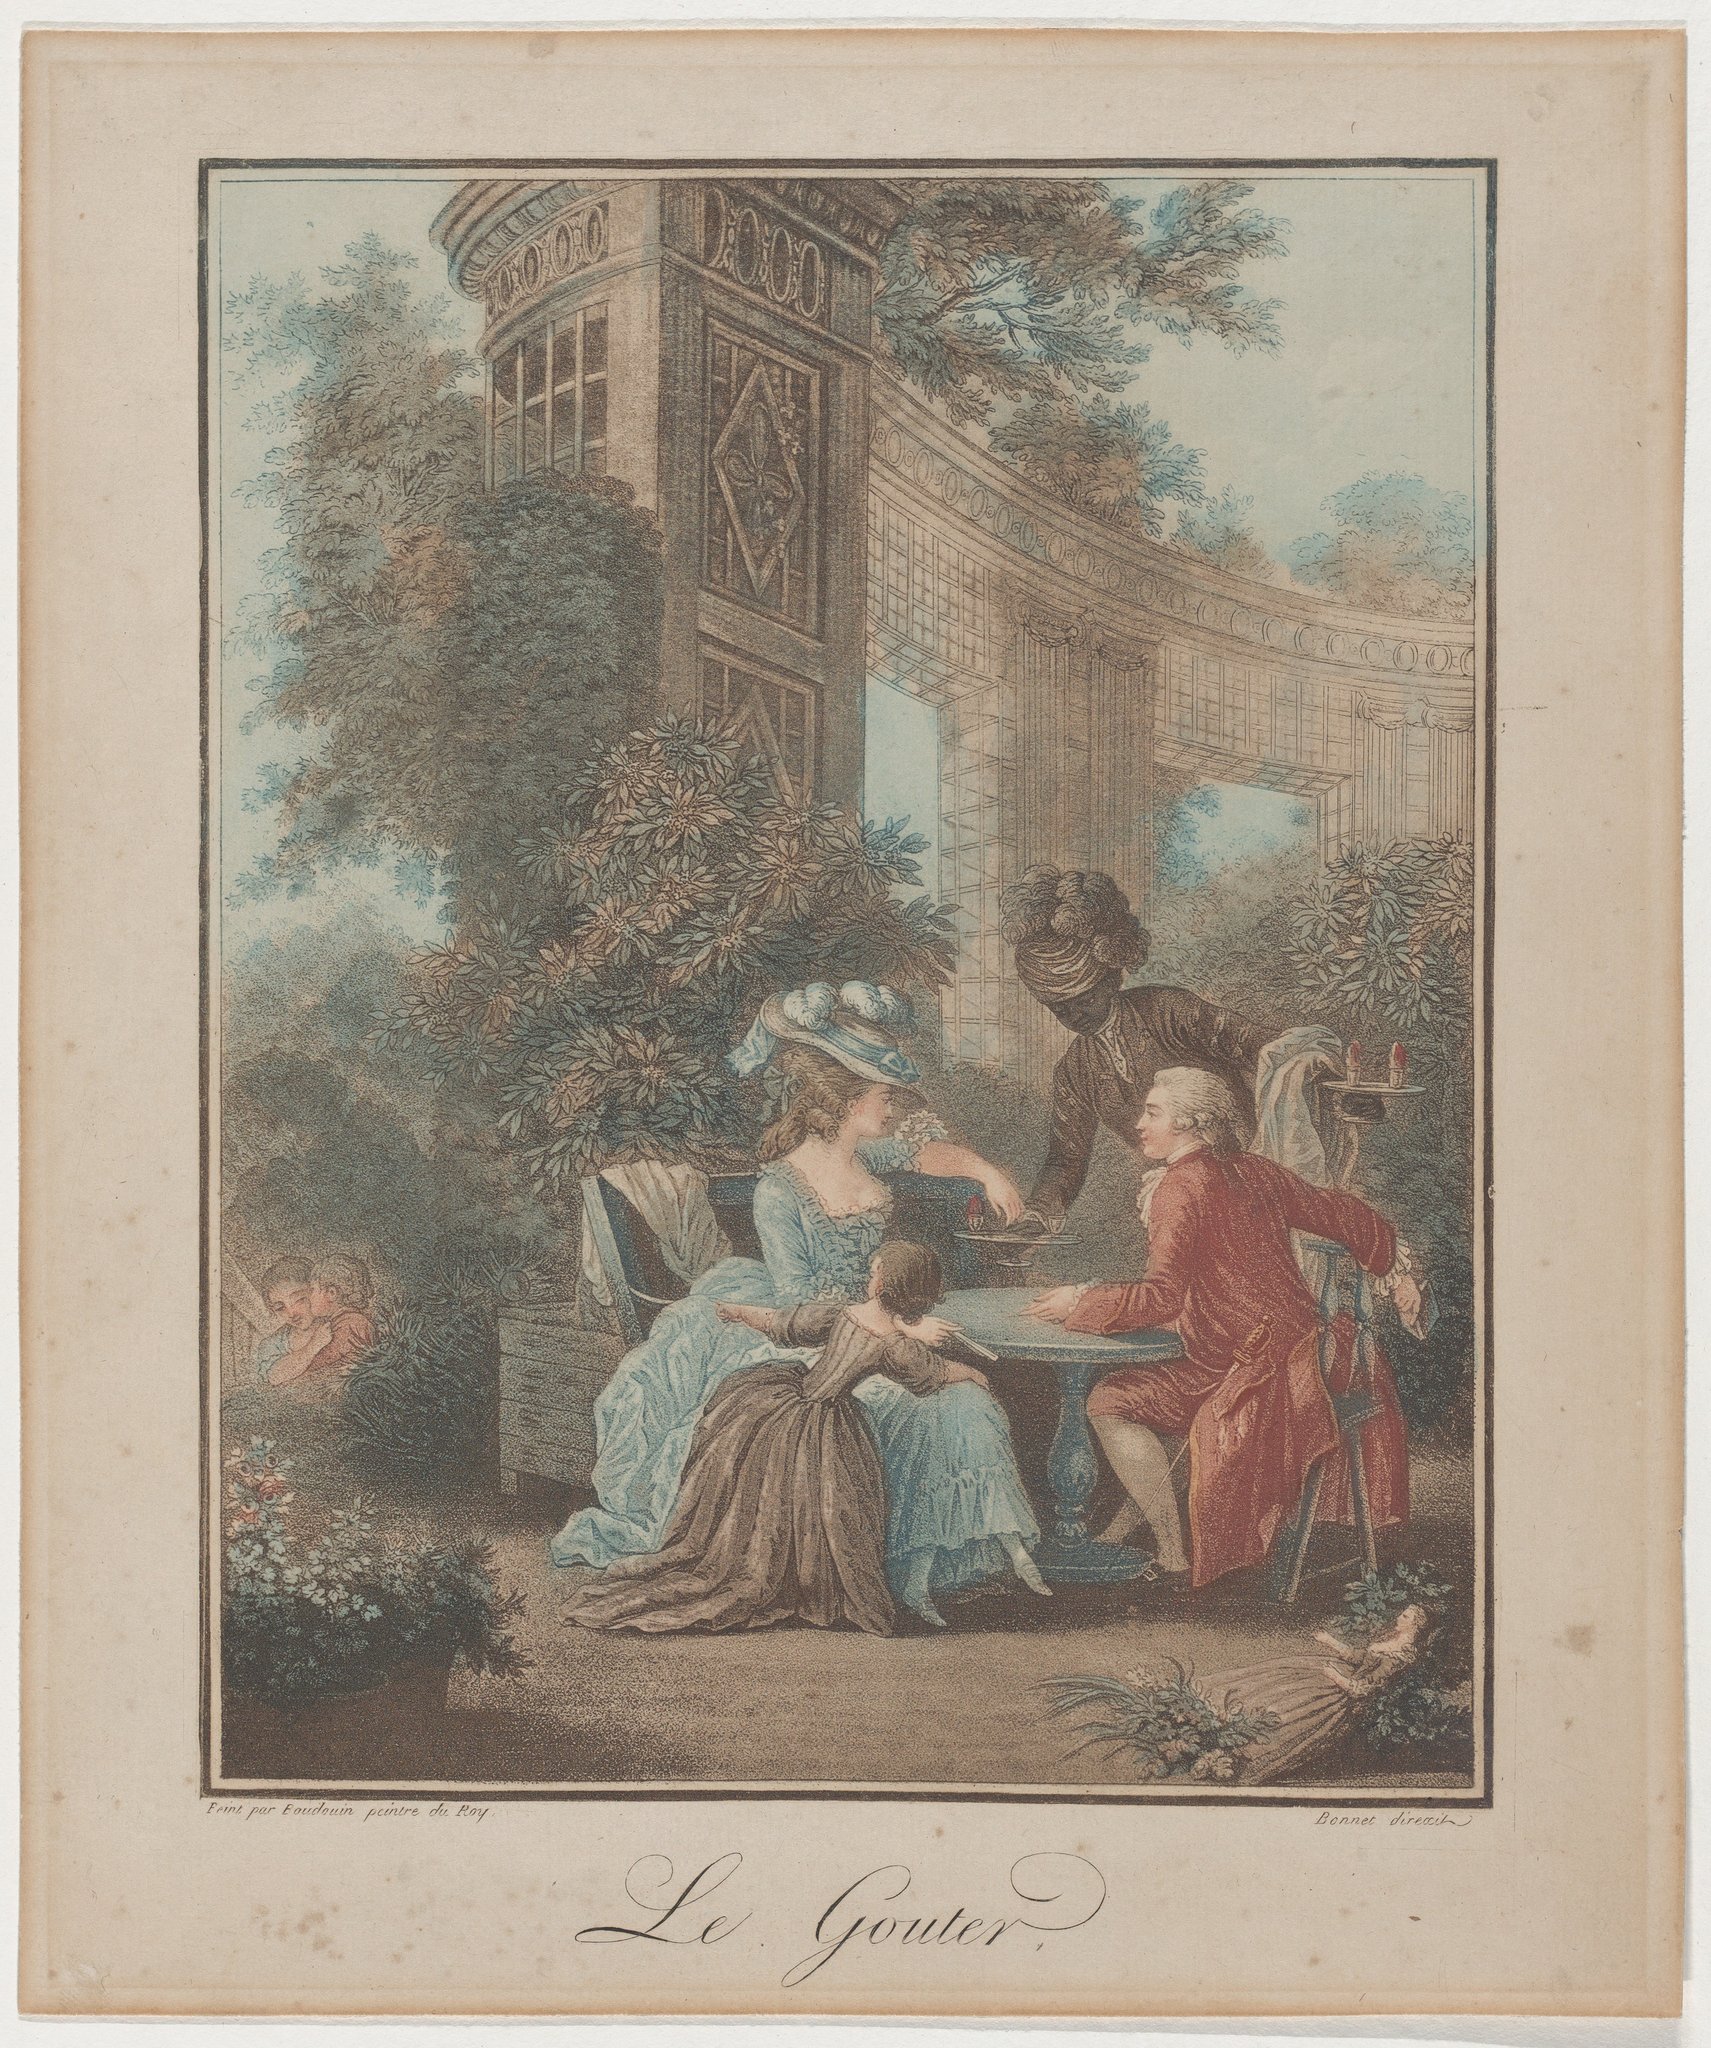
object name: print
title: The Snack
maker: louis marin bonnet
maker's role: artist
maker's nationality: french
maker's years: 1736-1793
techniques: stippling, wash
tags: food,girls,men,women